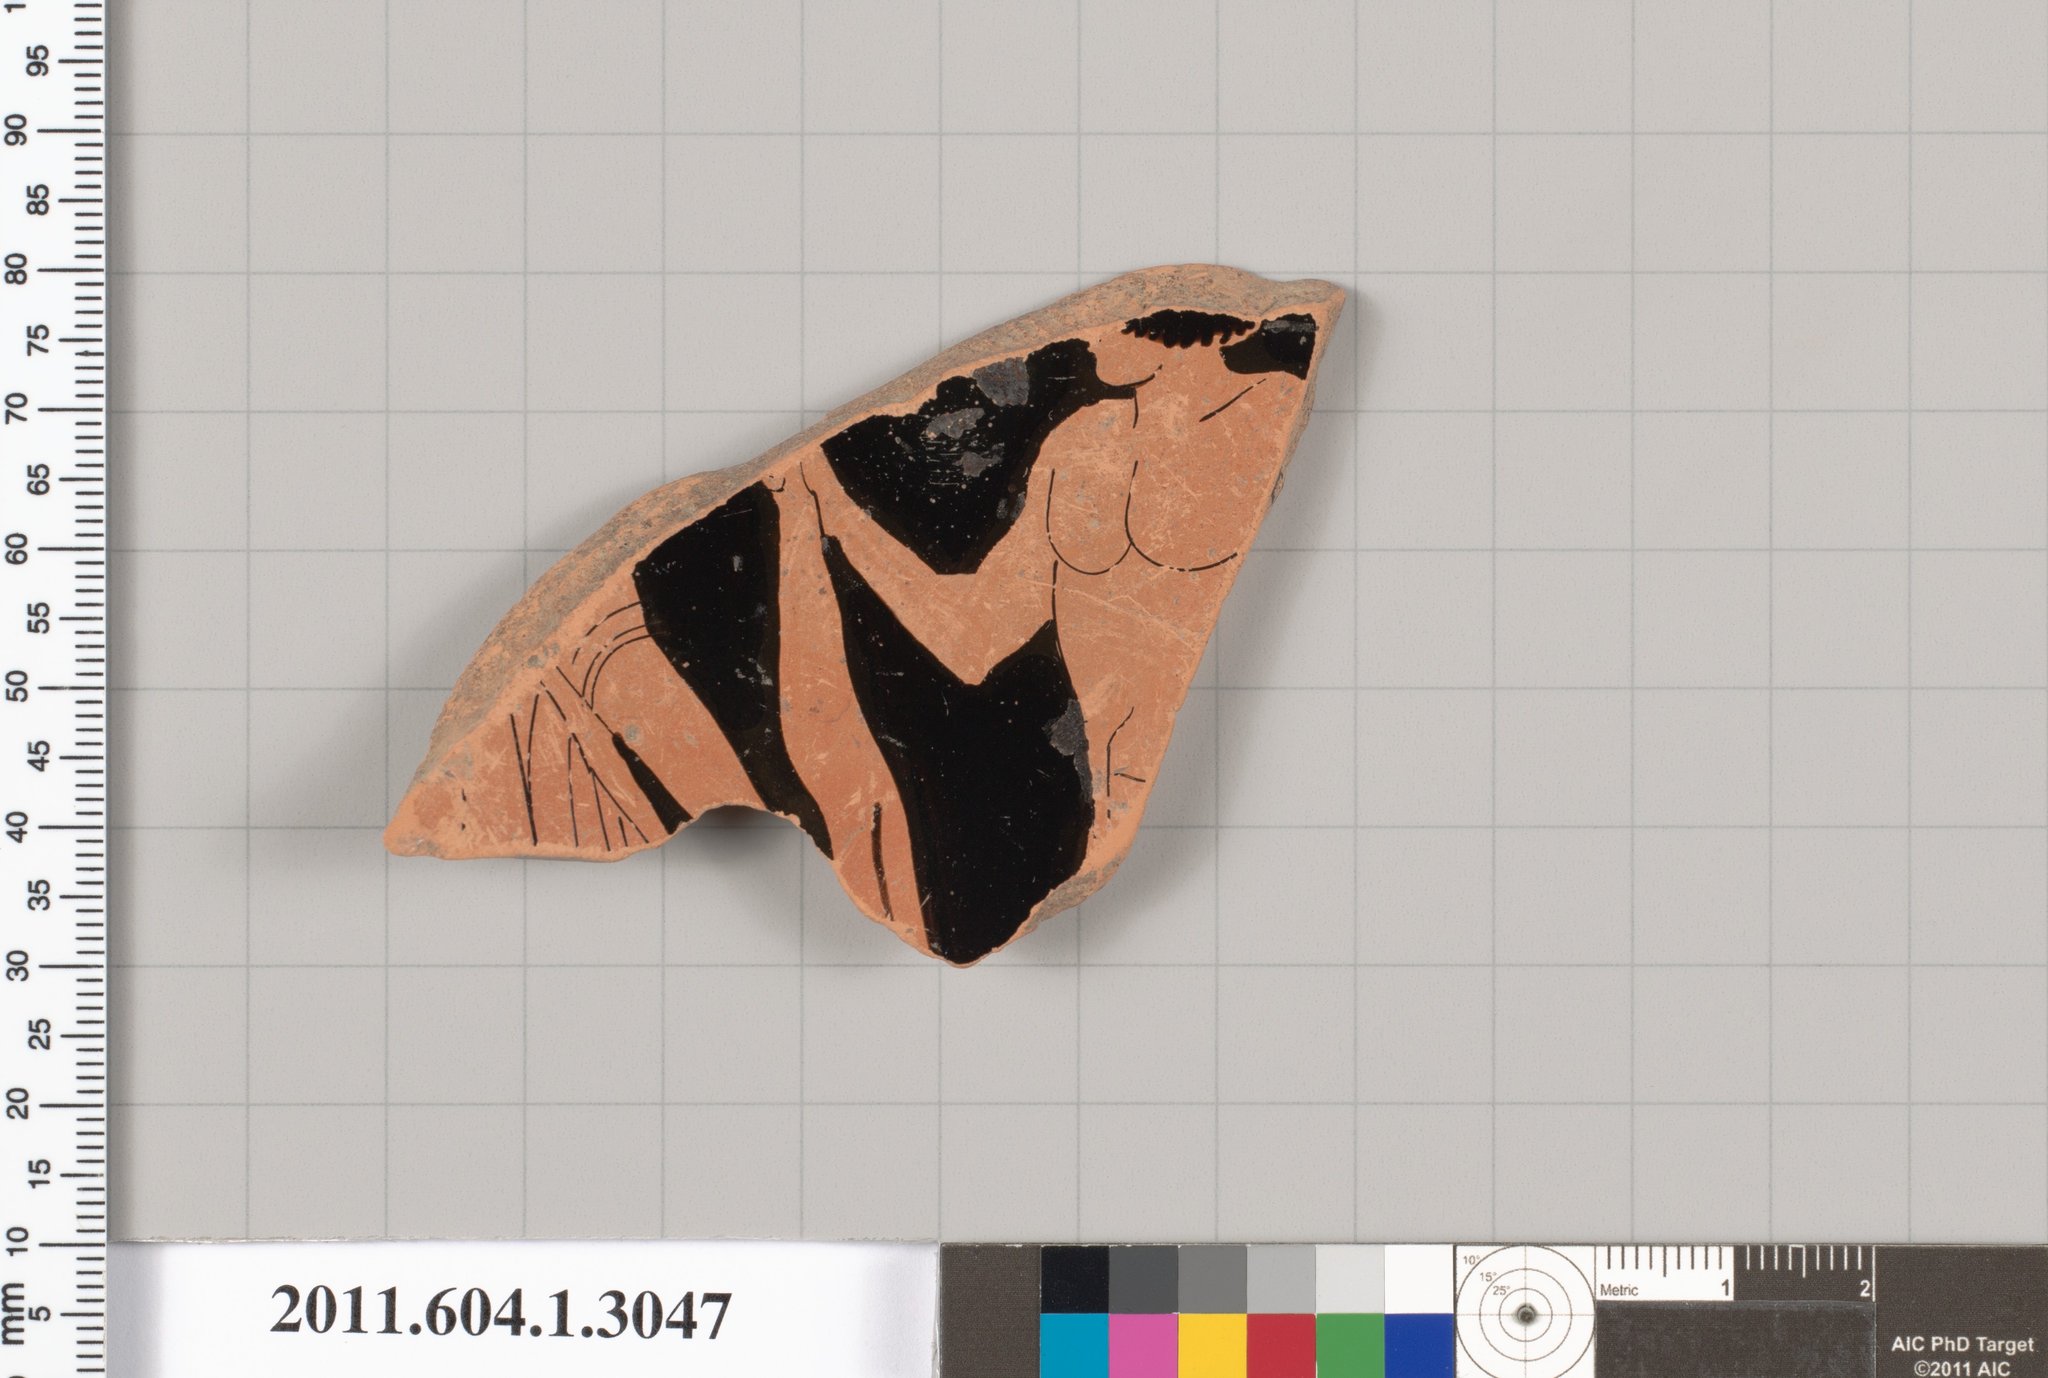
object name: kylix fragment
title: Terracotta fragment of a kylix (drinking cup)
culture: greek, attic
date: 480-460 BCE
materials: terracotta